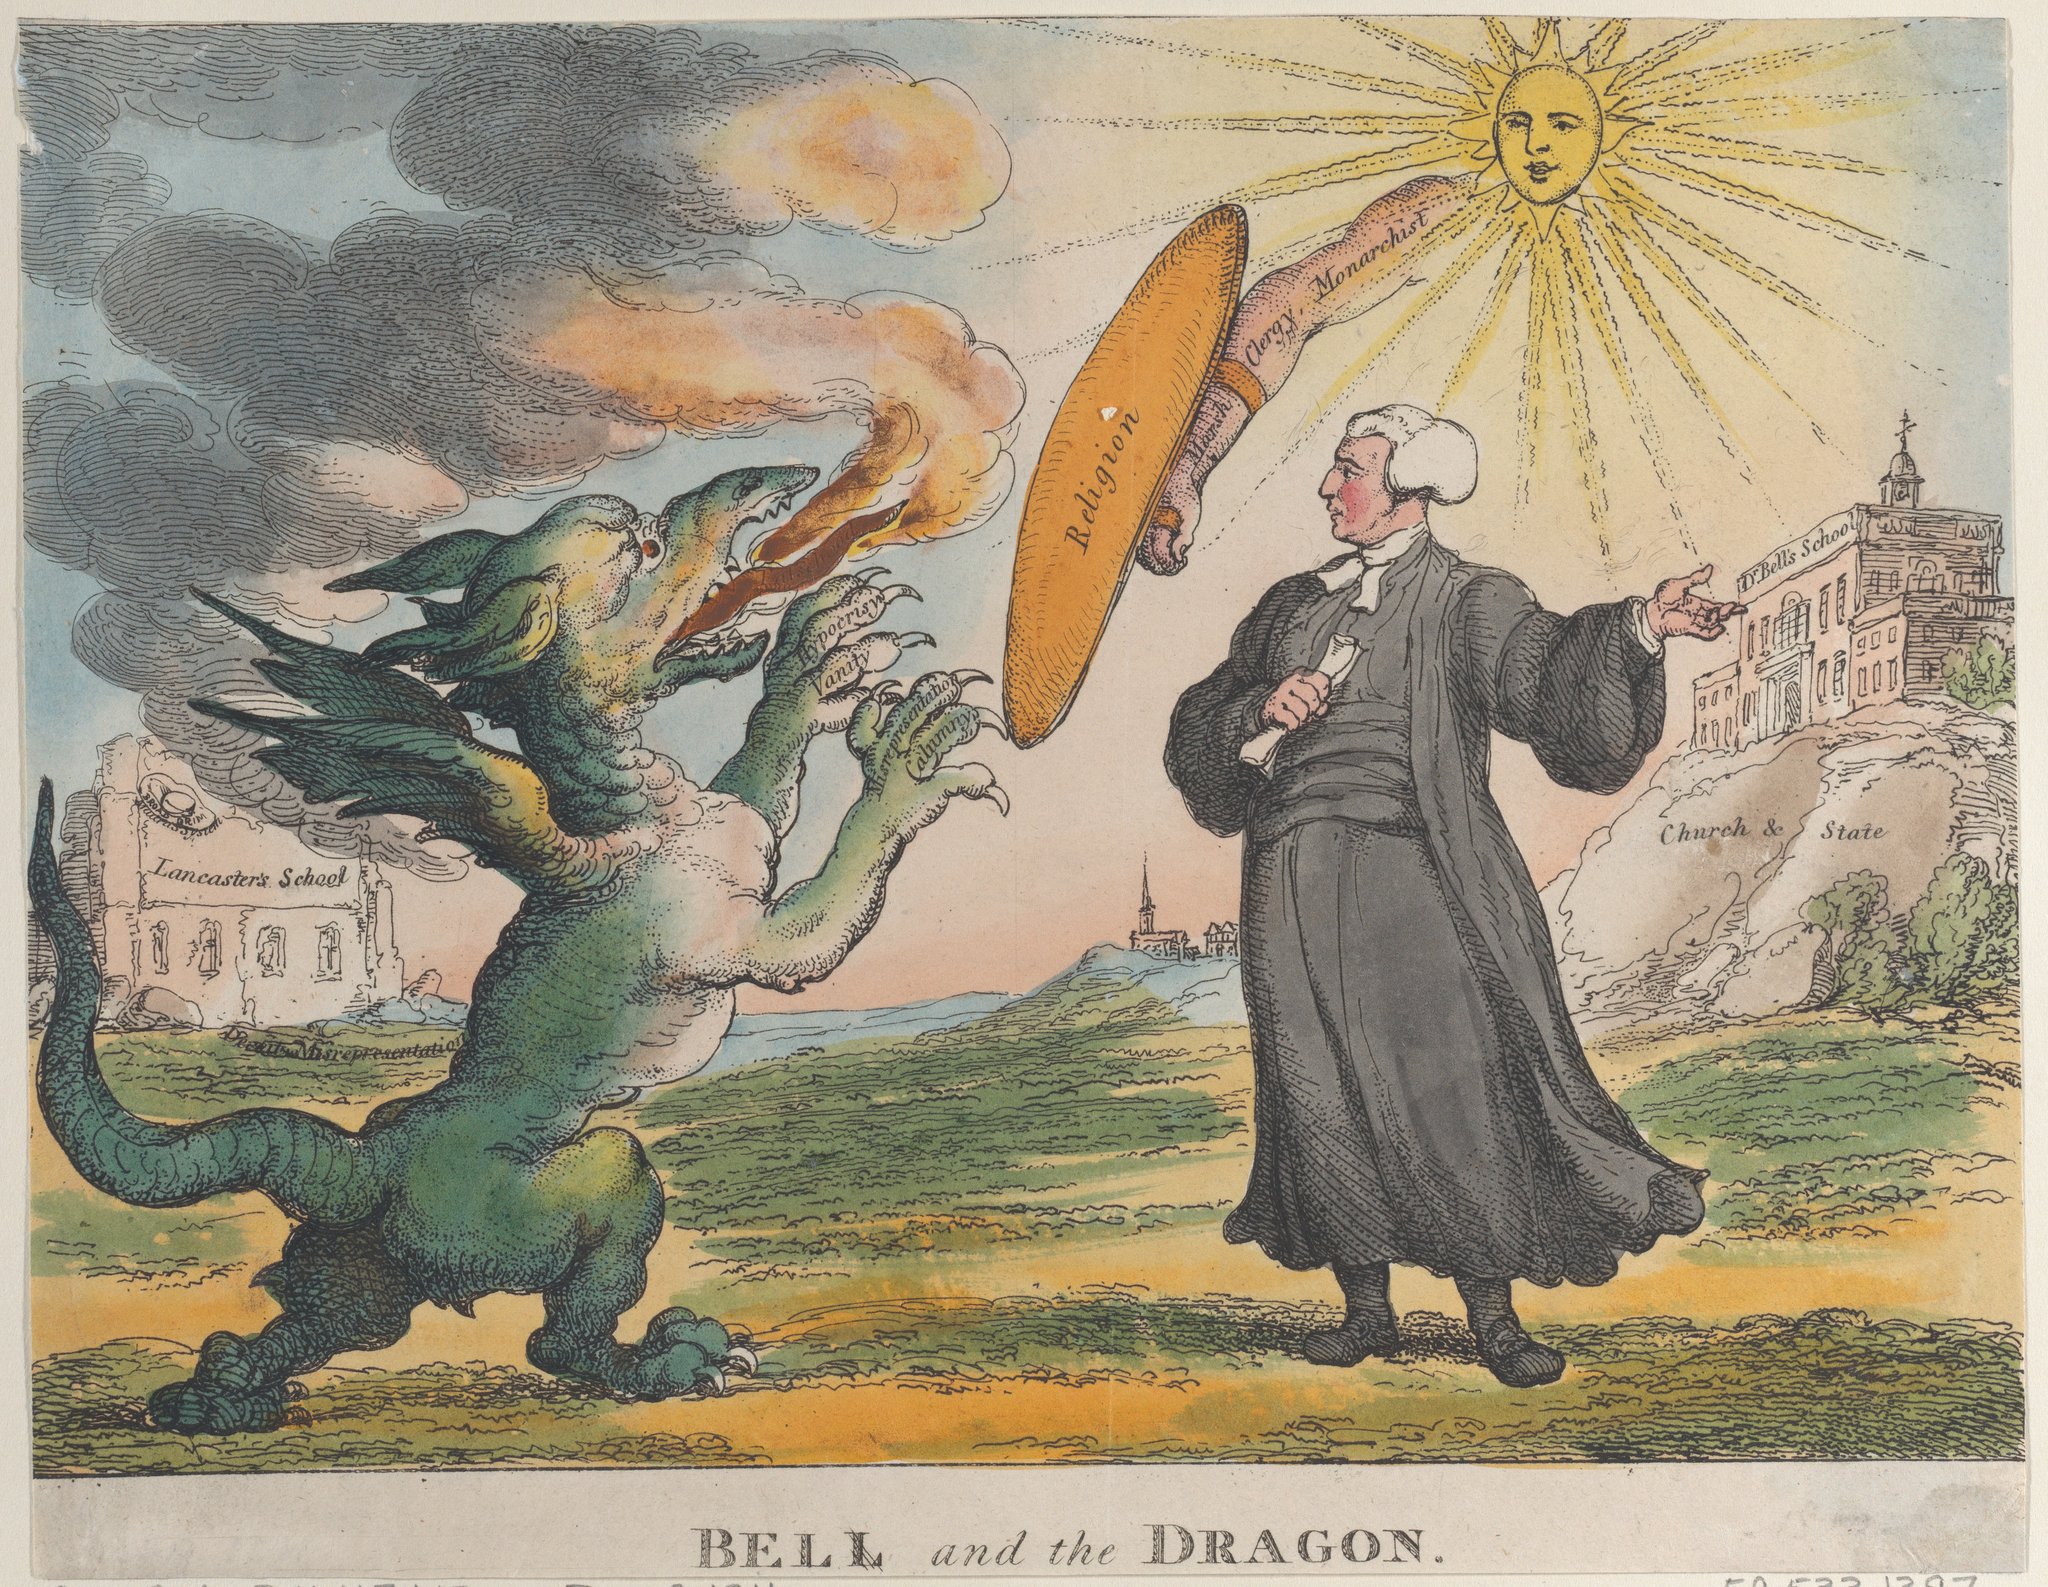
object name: print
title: Bell and the Dragon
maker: thomas rowlandson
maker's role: artist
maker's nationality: british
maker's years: 1757-1827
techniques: etching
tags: satire,men,dragons